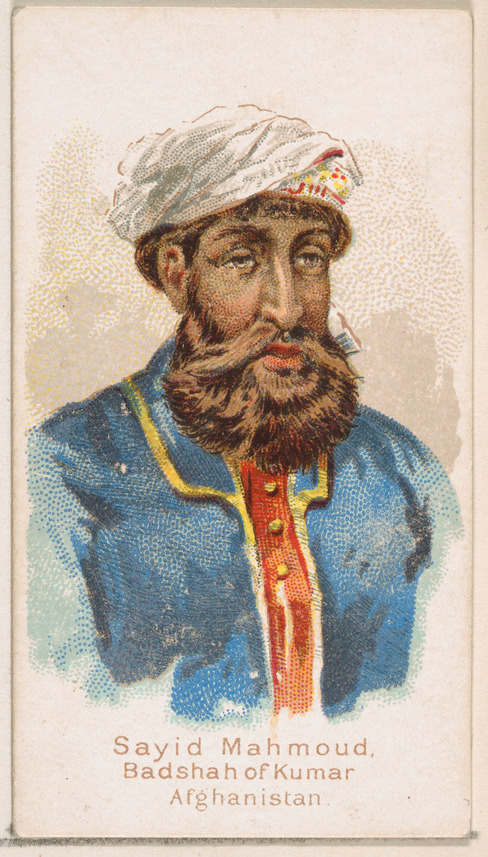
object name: print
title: Sayid Mahmoud, Badshah of Kumar, Afghanistan, from the Savage and Semi-Barbarous Chiefs and Rulers series (N189) issued by Wm. S. Kimball & Co.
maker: william s. kimball & company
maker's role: publisher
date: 1888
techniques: color lithograph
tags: men,portraits